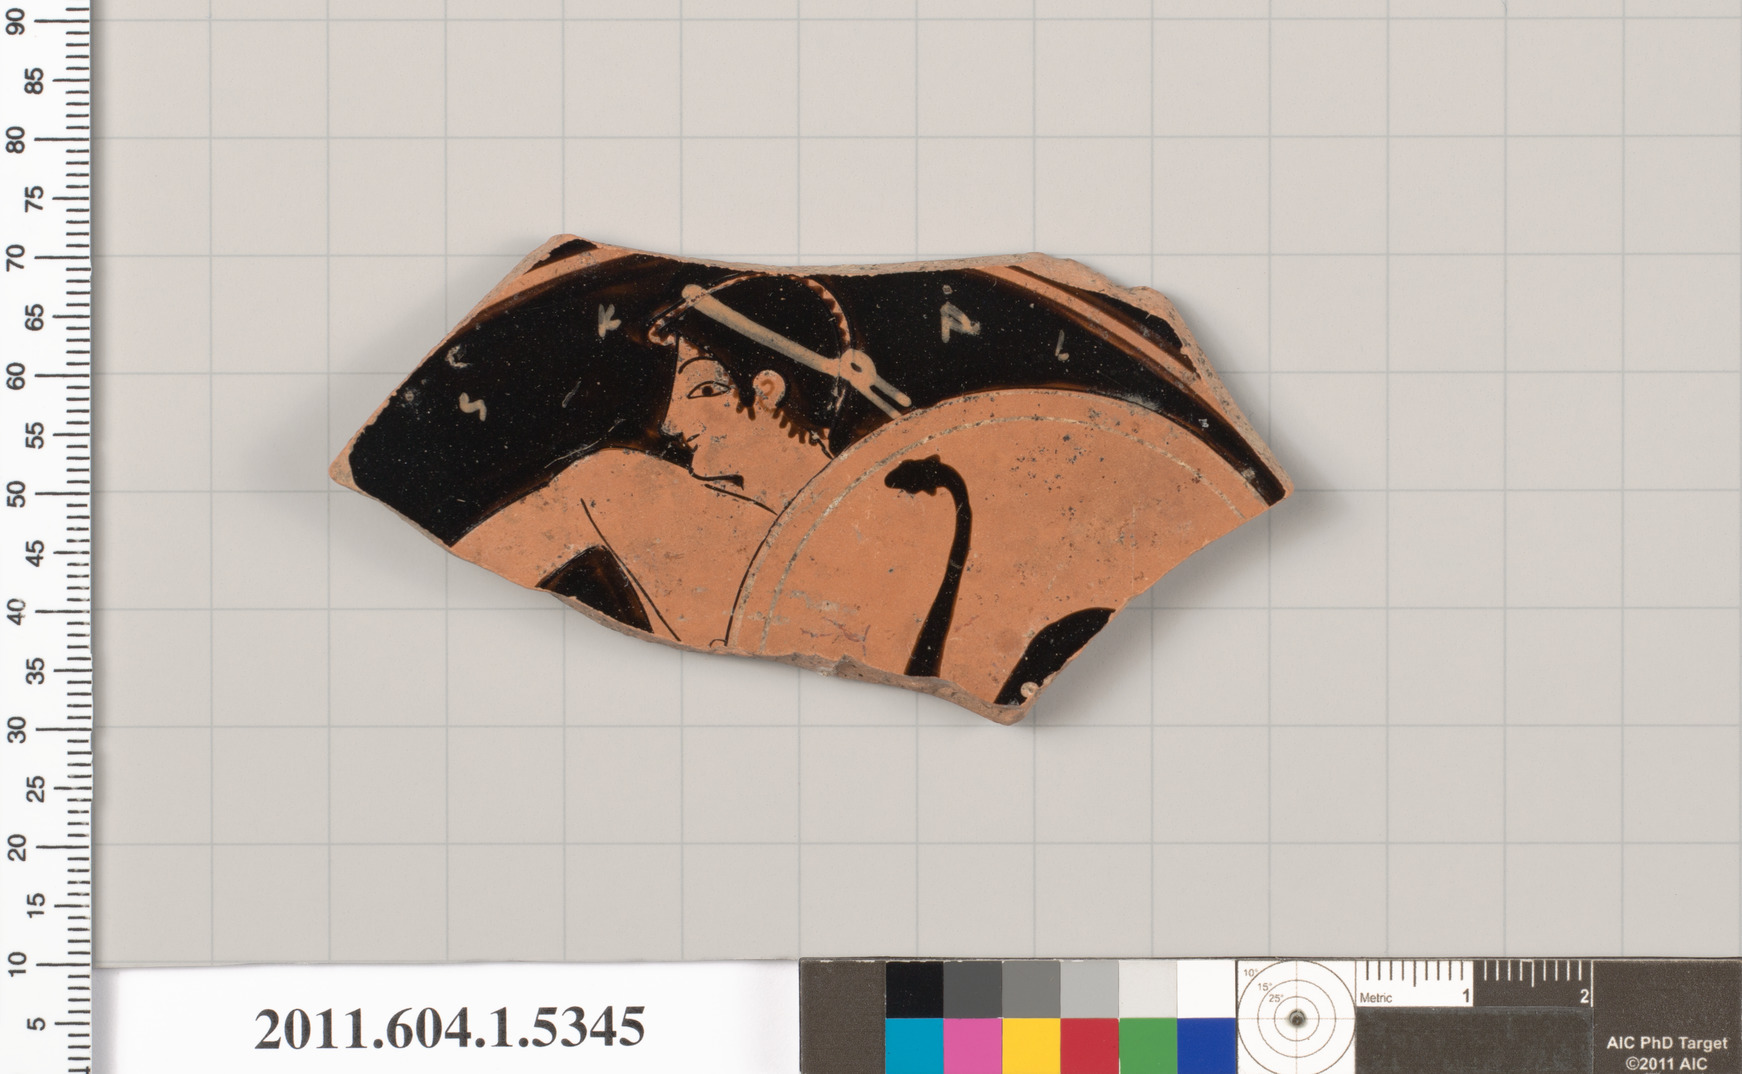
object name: kylix fragment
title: Terracotta fragment of a kylix (drinking cup)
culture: greek, attic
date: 510-490 BCE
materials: terracotta